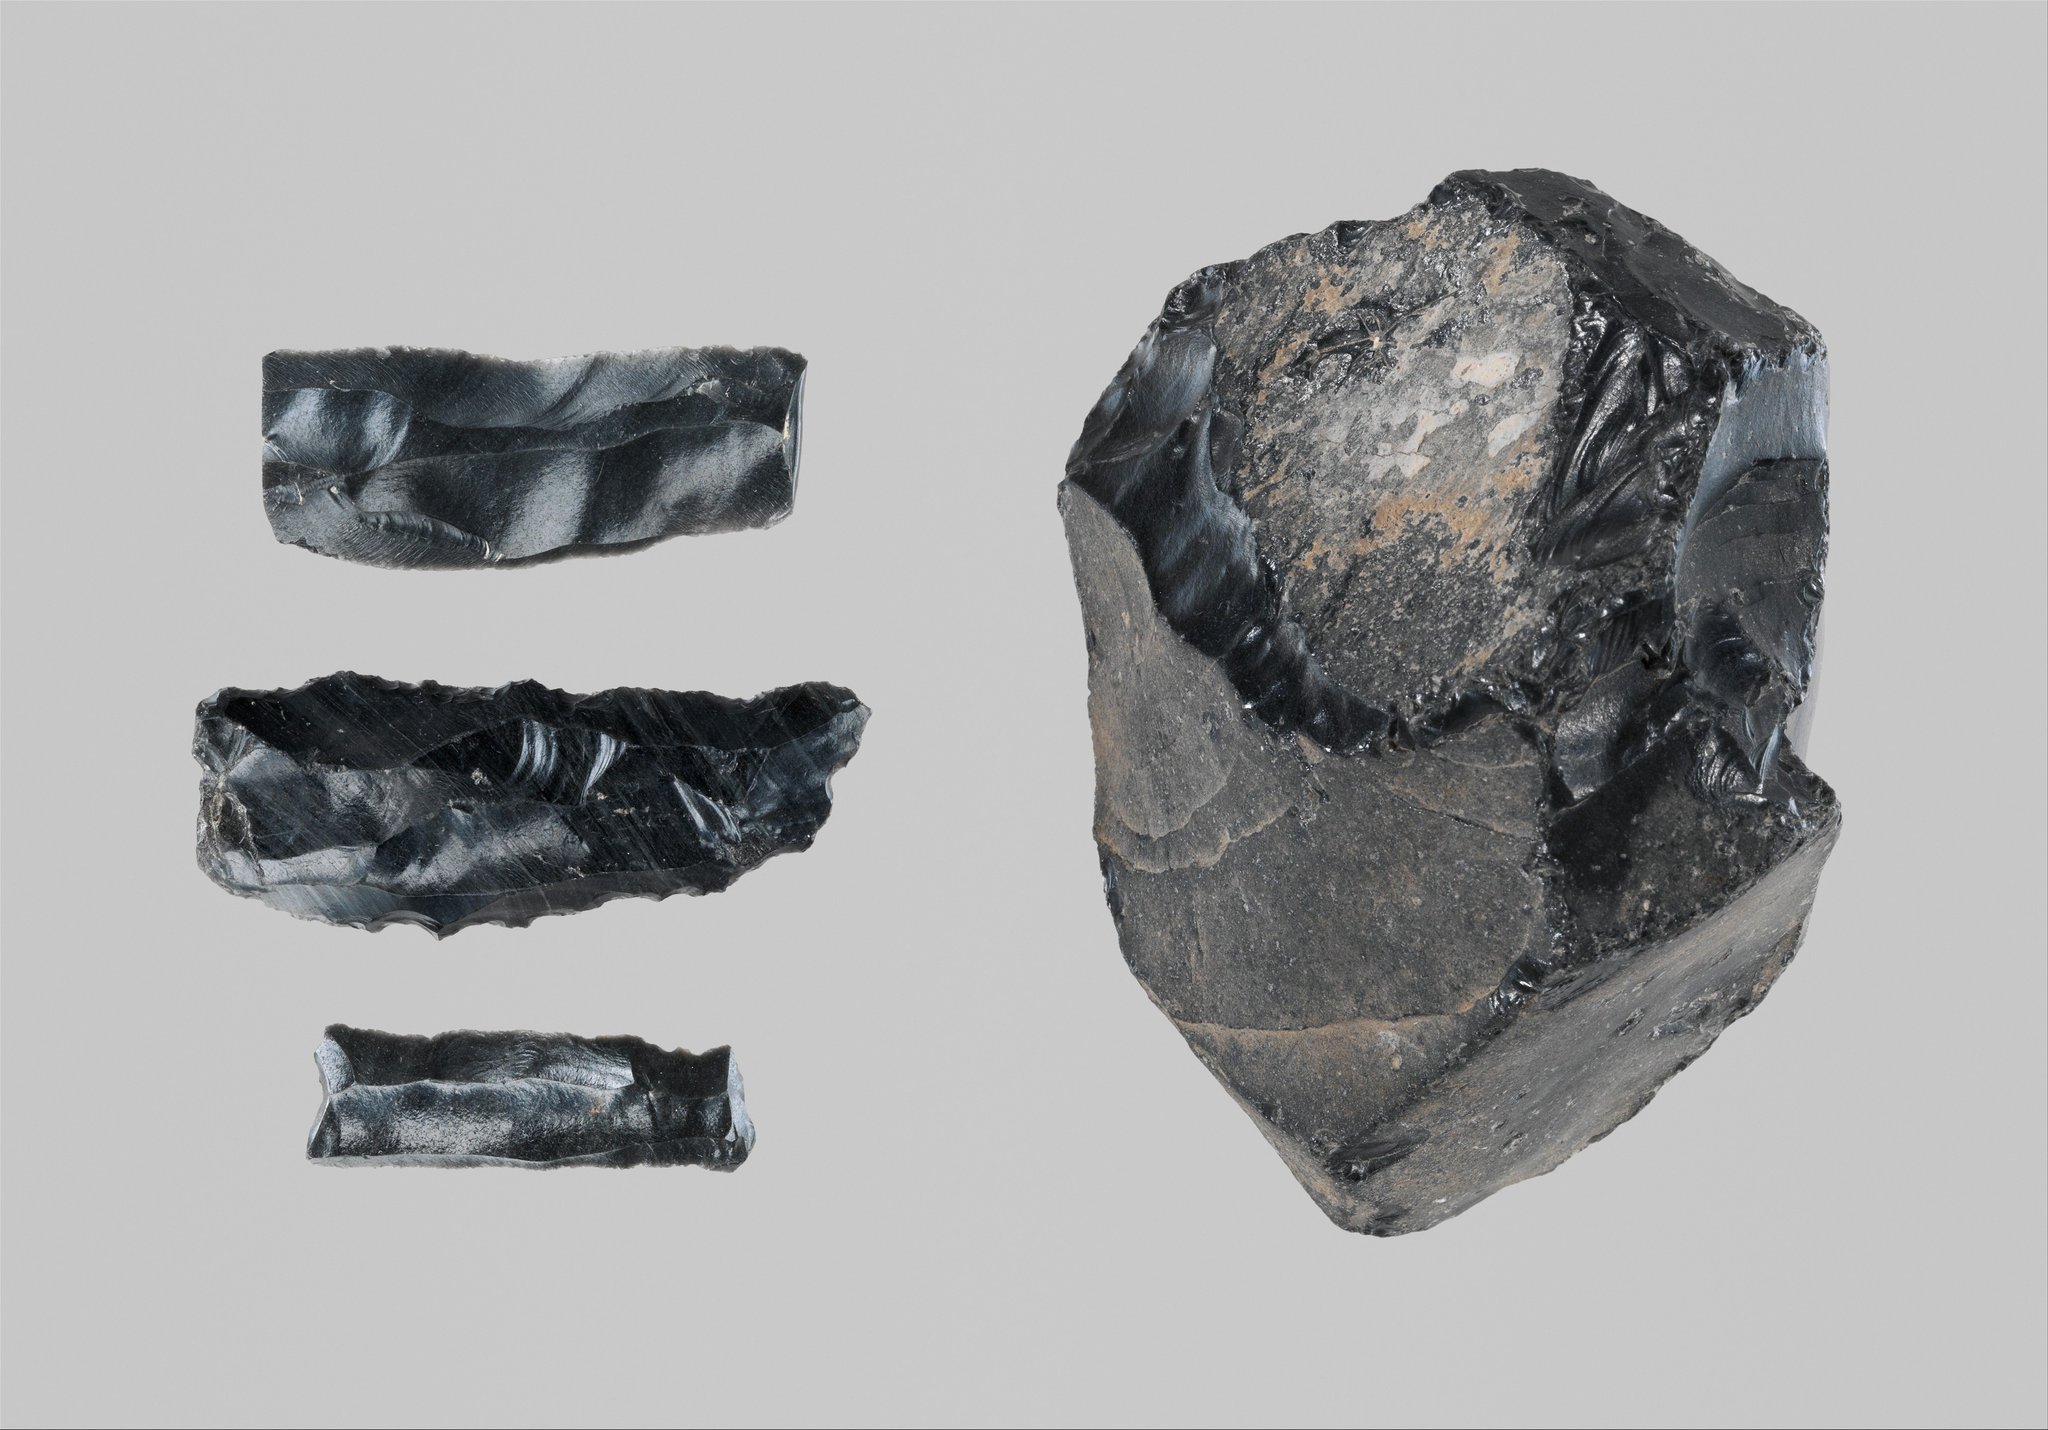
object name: 3 fragment of worked obsidian and a lump of obsidian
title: Group of 3 worked obsidian fragments and a raw obsidian lump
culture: cycladic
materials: obsidian